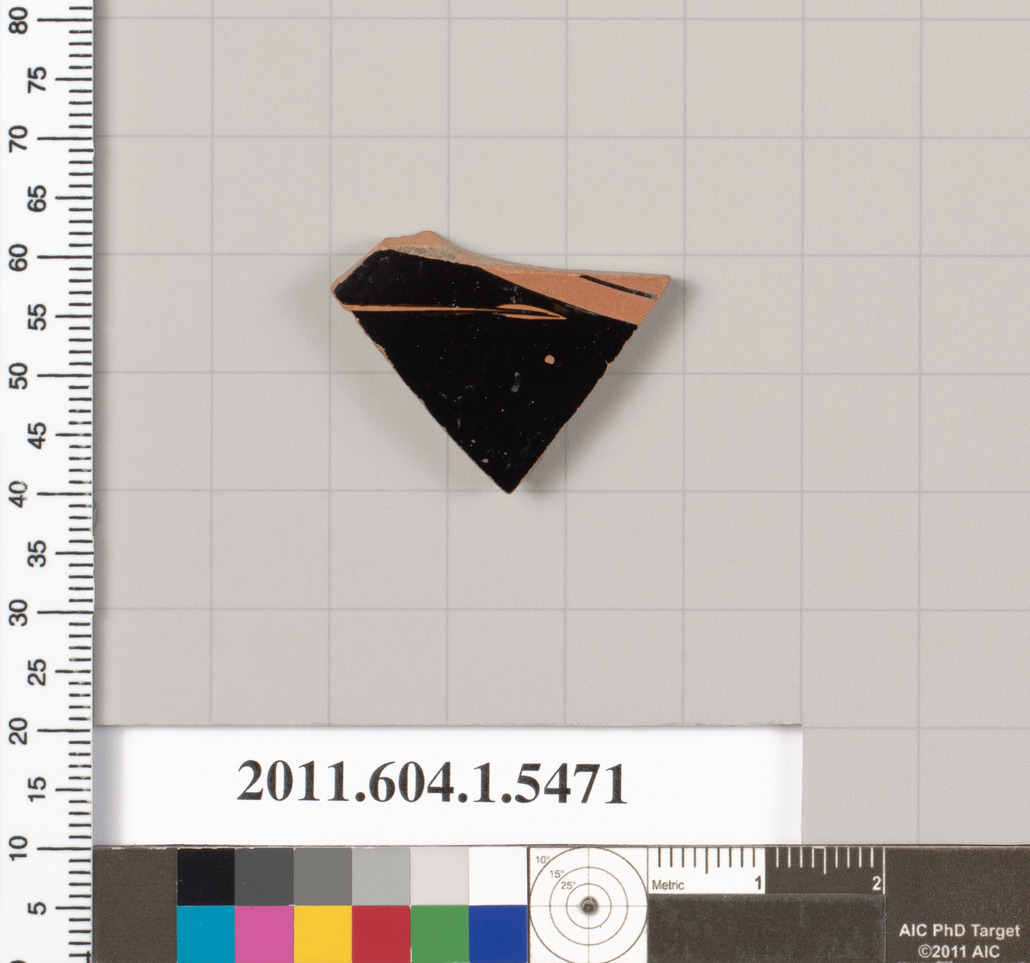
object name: kylix fragment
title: Terracotta fragment of a kylix (drinking cup)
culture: greek, attic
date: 520-500 BCE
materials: terracotta